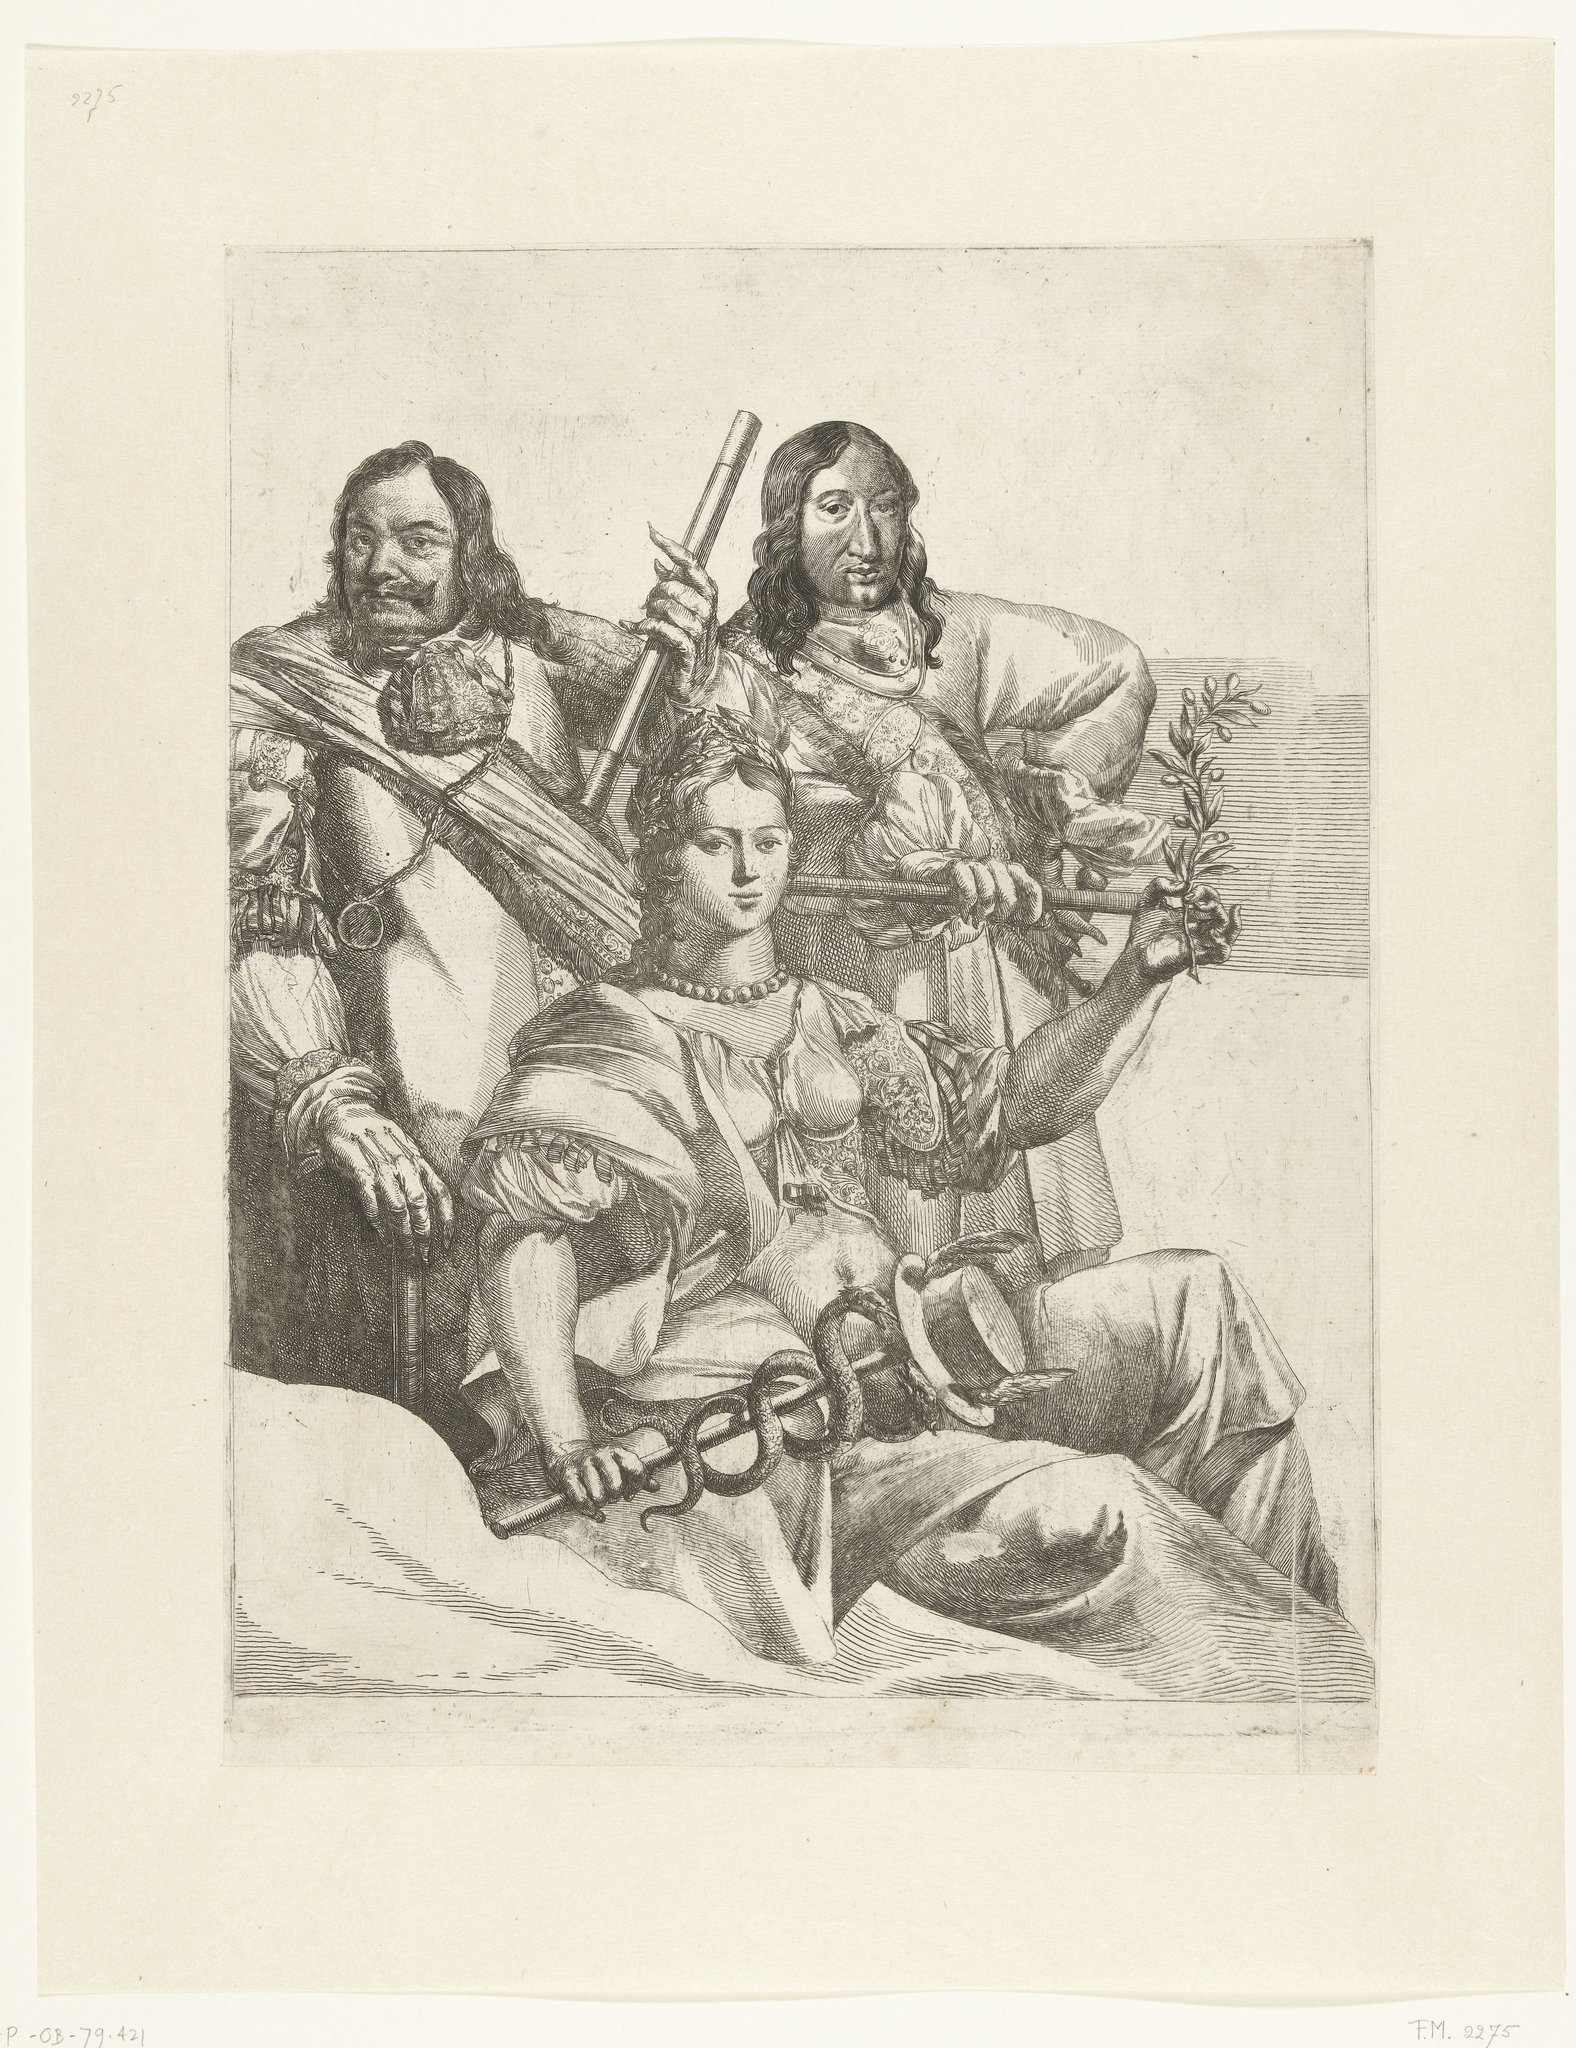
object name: print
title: Allegorisch portret van de admiraals Michiel Adriaenszoon de Ruyter en Willem Joseph Baron van Ghent, ca. 1667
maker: romeyn de hooghe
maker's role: draughtsman, goldsmith, painter, print maker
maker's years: 1645-1708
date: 1667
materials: paper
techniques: engraving, etching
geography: northern netherlands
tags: flushing, michiel adriaenszoon de ruyter, willem joseph baron van gendt, symbols, allegories of peace, 'pax'; 'pace' (ripa), raid on the medway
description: Allegorisch portret van de admiraals Michiel Adriaenszoon de Ruyter en Willem Joseph Baron van Ghent, ca. 1667. Op de voorgrond de zittende personificatie van de Vrede, in de handen de mercuriusstaf en een olijftak.